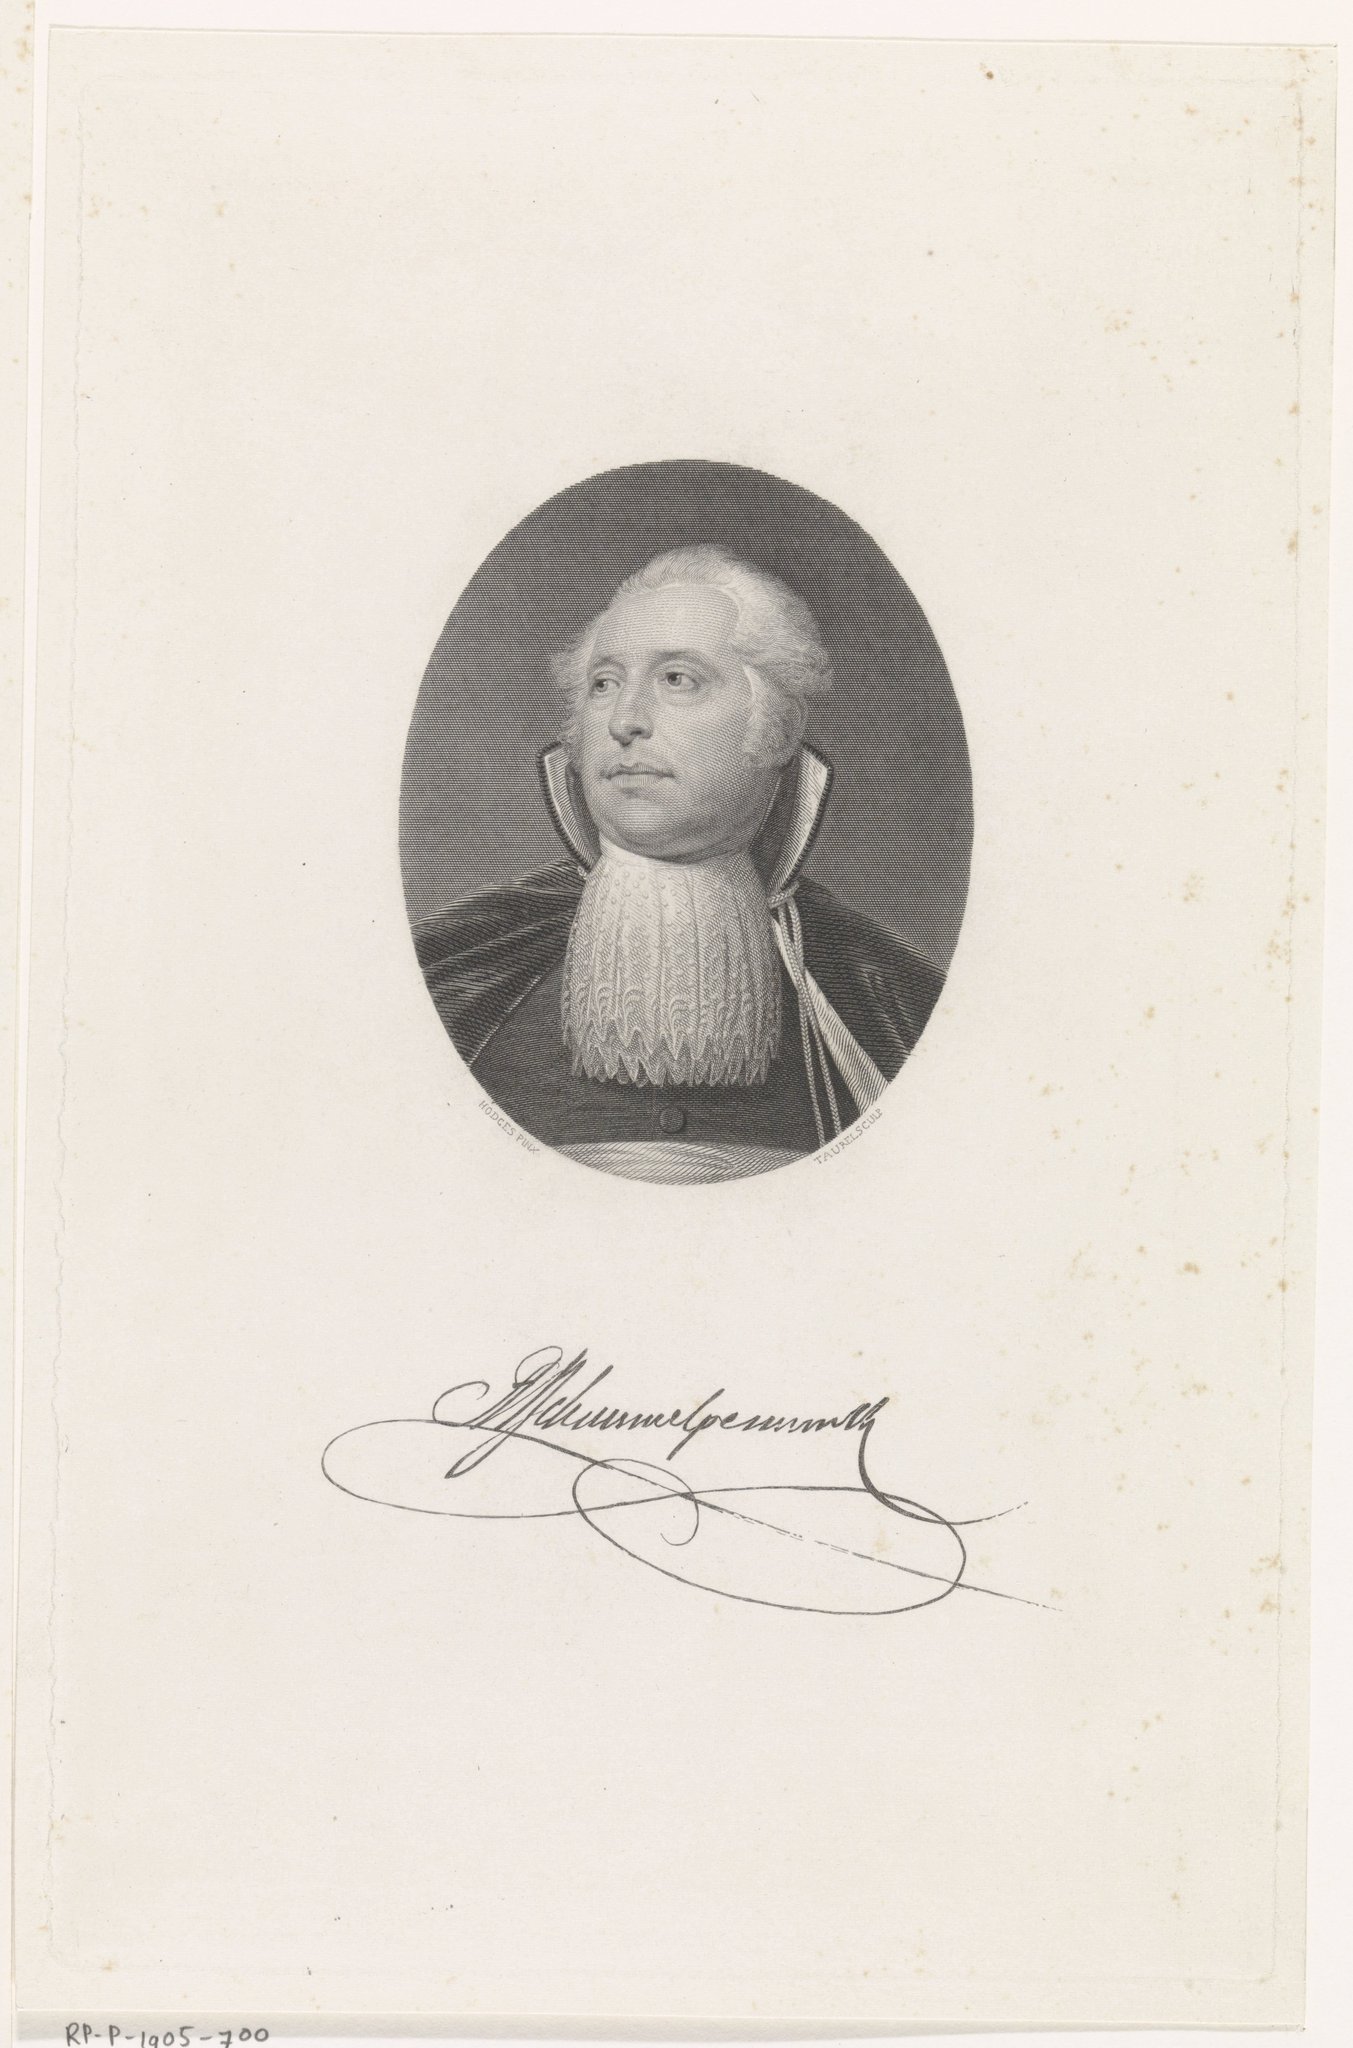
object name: print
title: Portret van Rutger Jan Schimmelpenninck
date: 1834-1891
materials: paper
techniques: engraving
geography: amsterdam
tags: rutger jan schimmelpenninck (1761-1825)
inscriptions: collector's mark: Lugt 2228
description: Portret van de rechtsgeleerde en raadspensionaris van de Bataafse republiek Rutger Jan Schimmelpenninck.